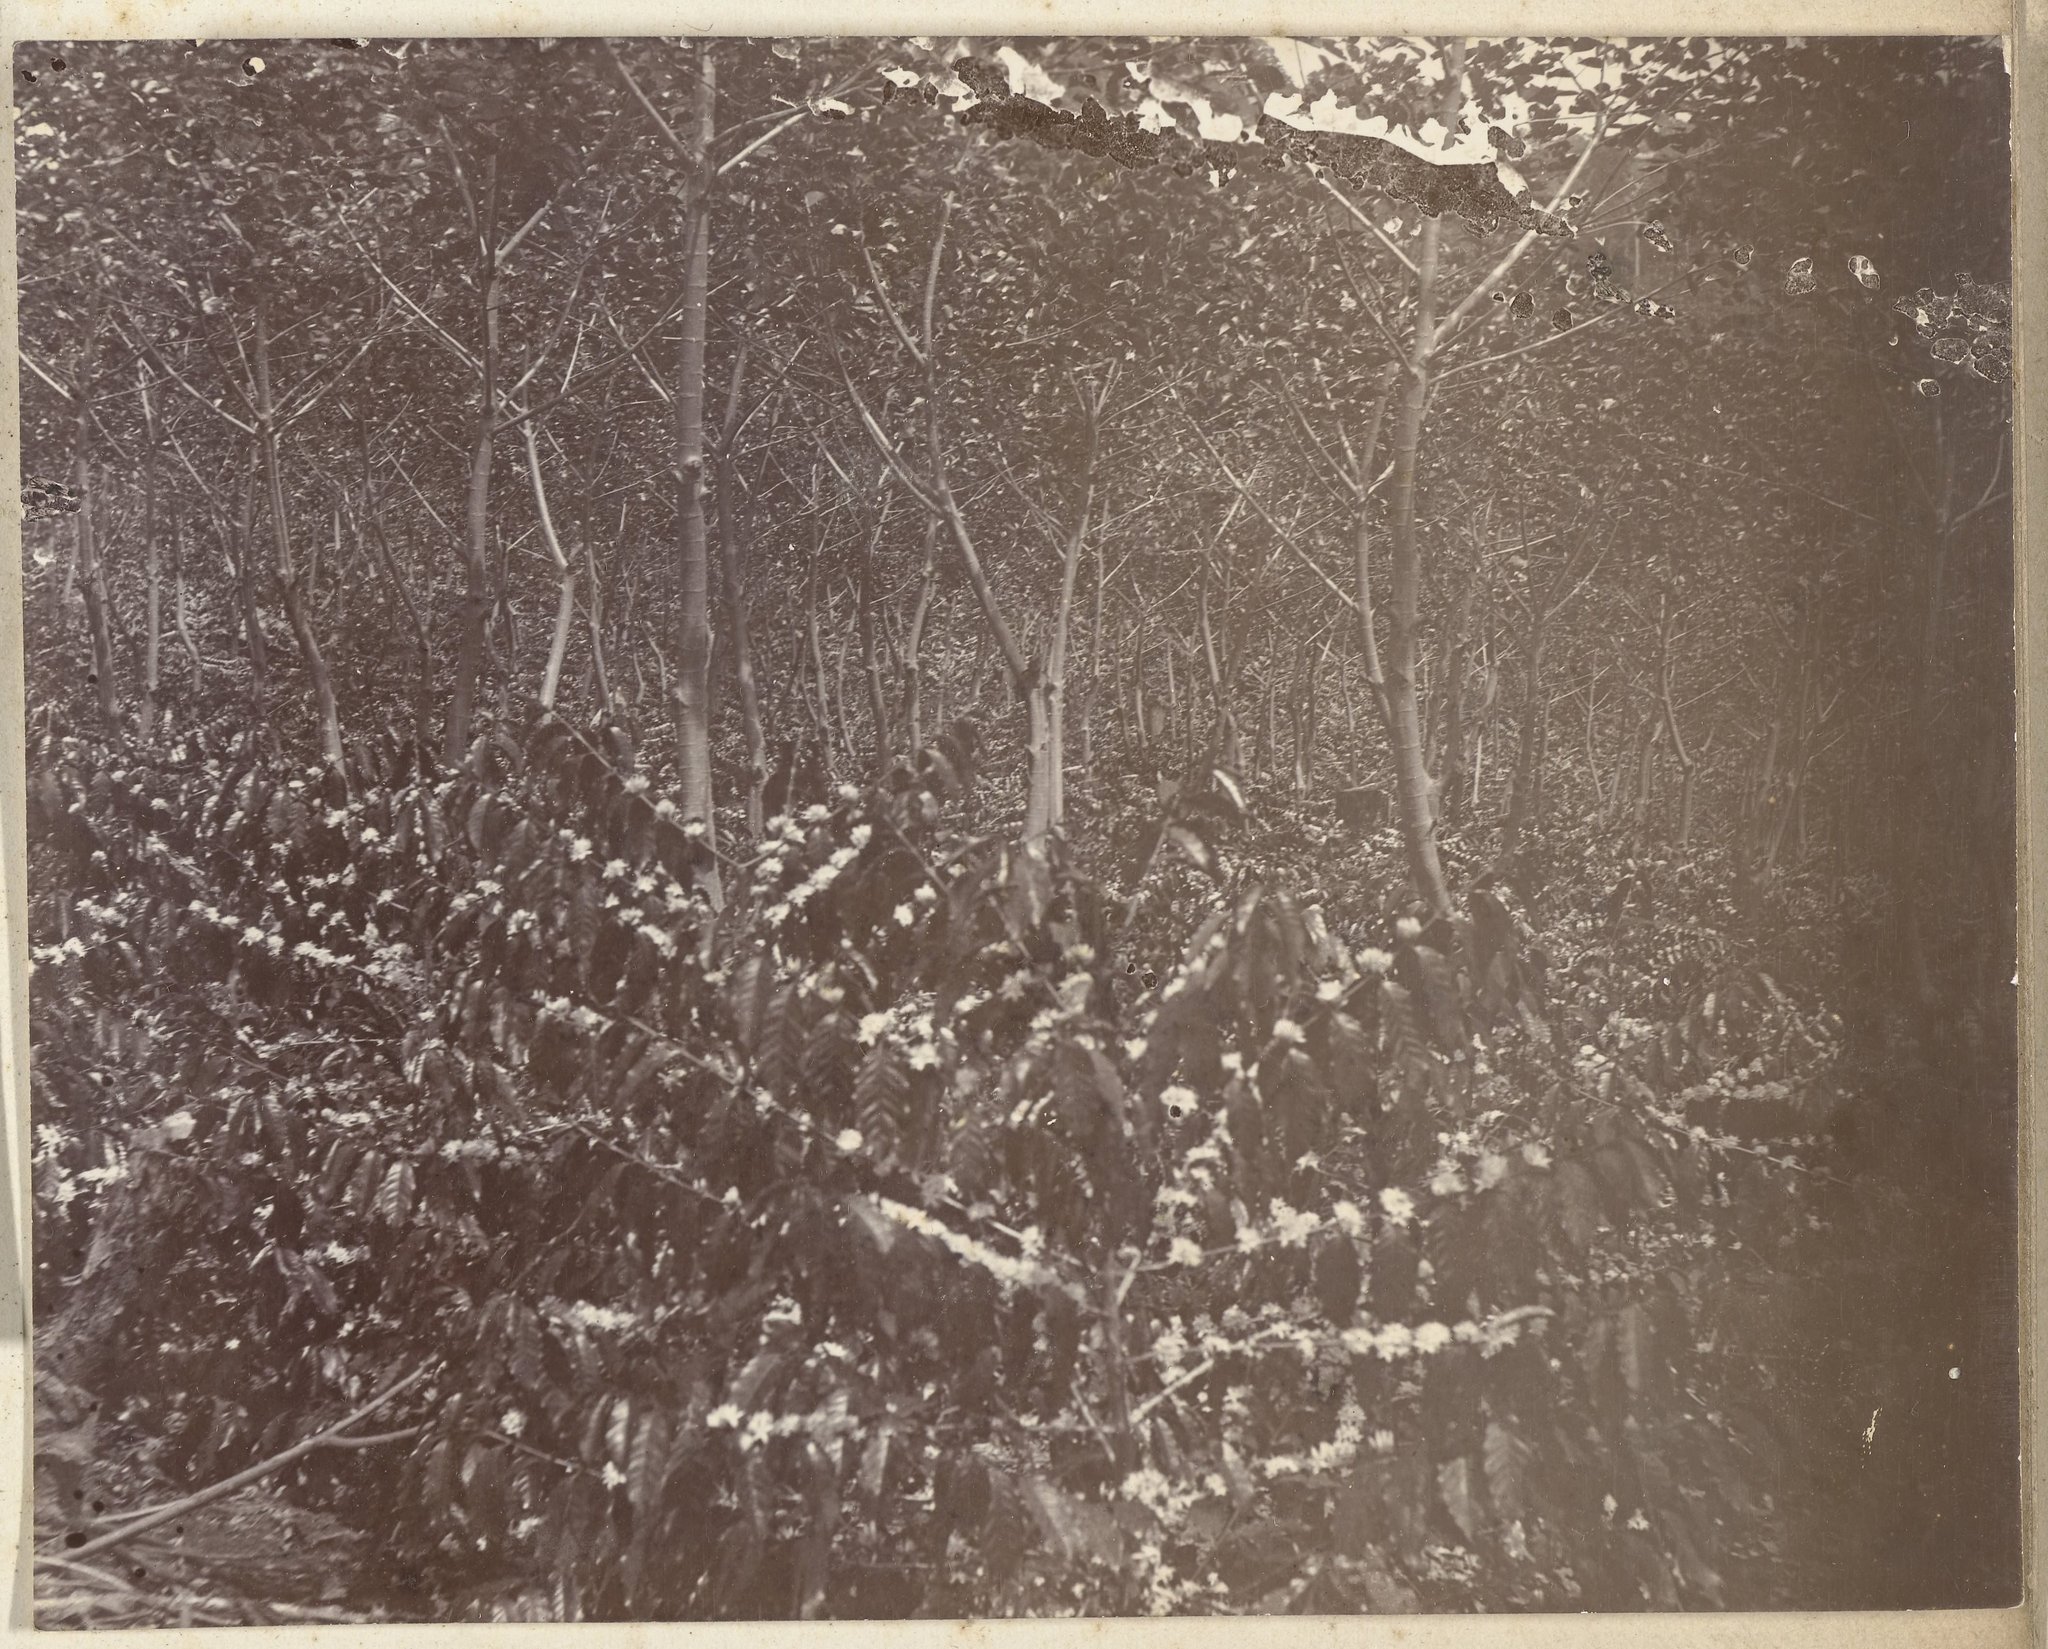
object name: photograph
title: Koffieplanten op plantage Silo Sanen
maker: Anonymous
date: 1890-1910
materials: cardboard, photographic support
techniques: gelatin silver print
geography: netherlands